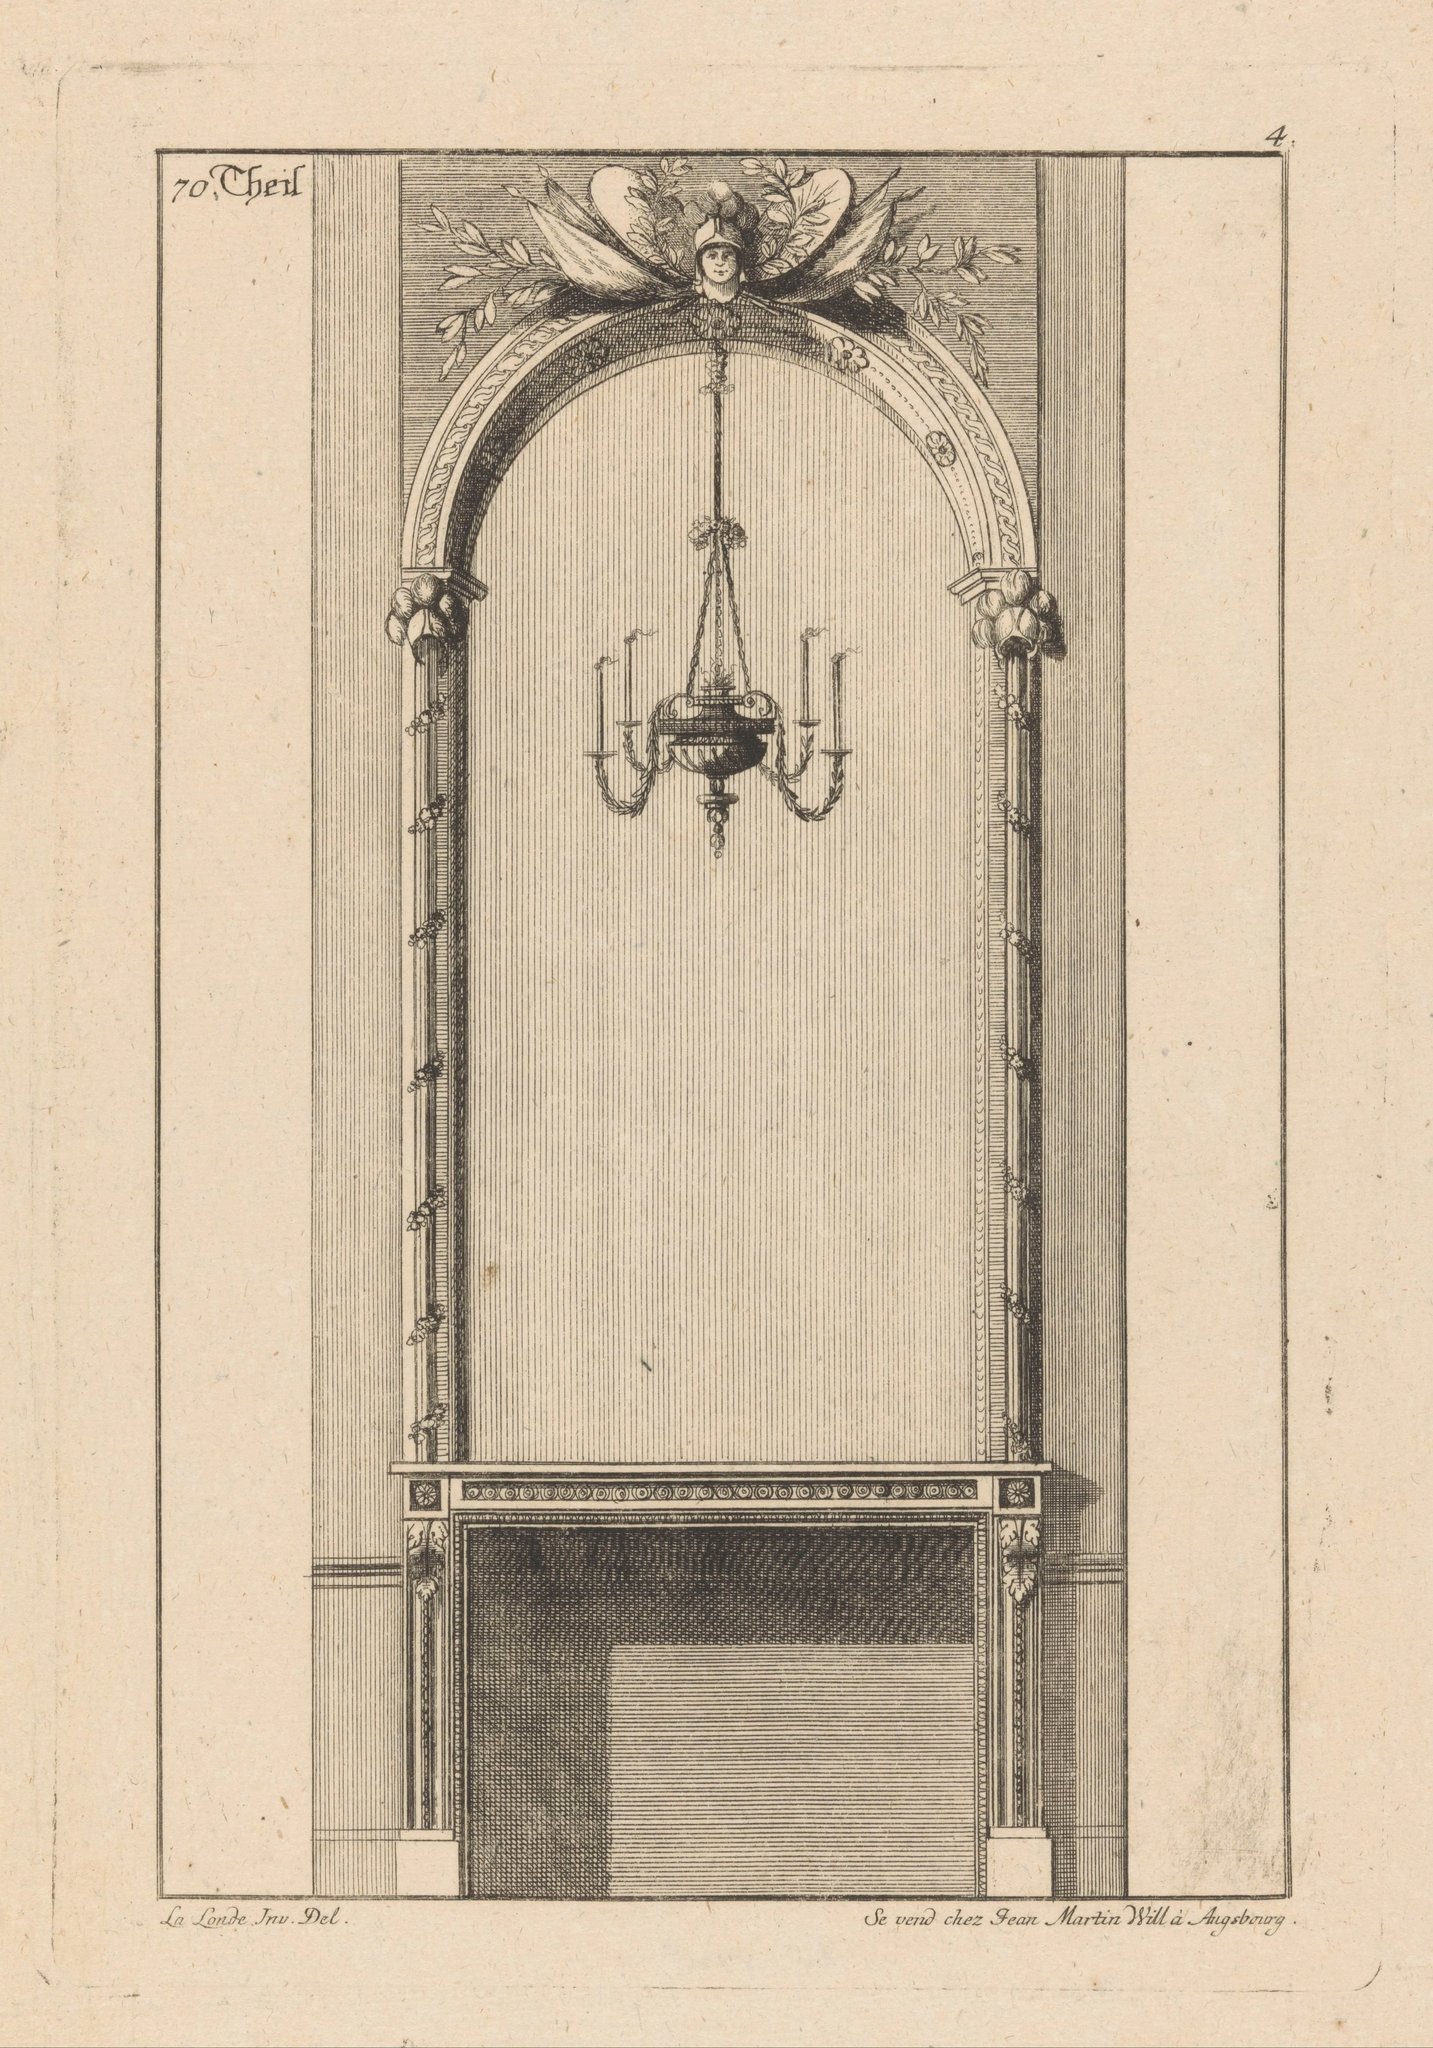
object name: print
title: Schouw met kroonluchter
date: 1784-1806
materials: paper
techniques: engraving, etching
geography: augsburg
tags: chandelier, candelabrum, open hearth, fire-place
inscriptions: collector's mark: Lugt 2760, collector's mark: Lugt 2228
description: Een geornamenteerde schouw met een vierarmige kroonluchter en twee helmen. Aan de bovenzijde een figuur met een helm, een lauwerkrans, schilden, vlaggen en ranken.